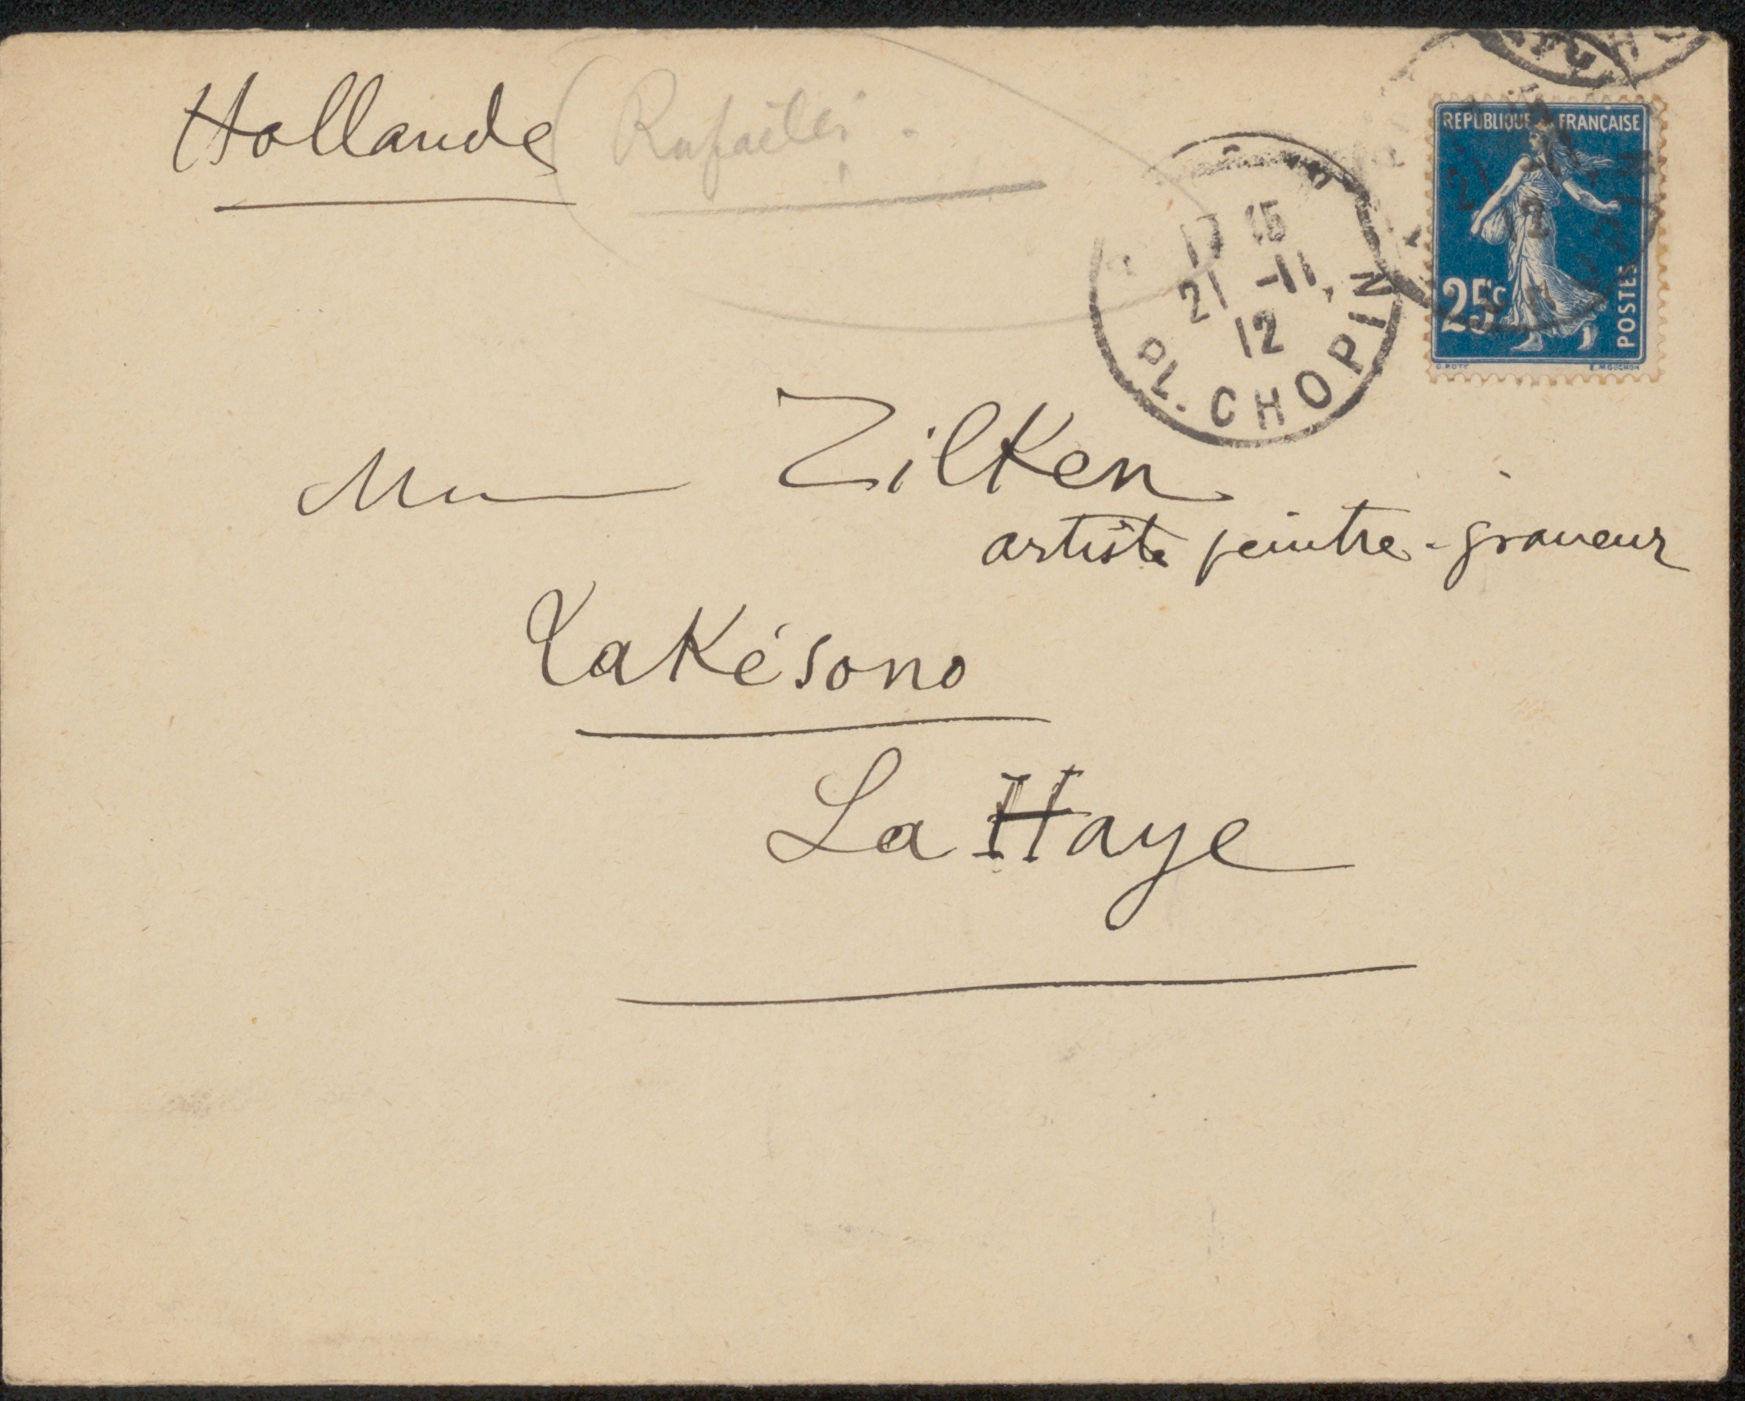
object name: envelope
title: Envelop aan Philip Zilcken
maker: jean françois raffaëlli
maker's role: print maker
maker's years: 1850-1924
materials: ink, paper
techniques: pen, writing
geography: paris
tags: painter, draughtsman, philip zilcken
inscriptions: collector's mark: ‘RPK’